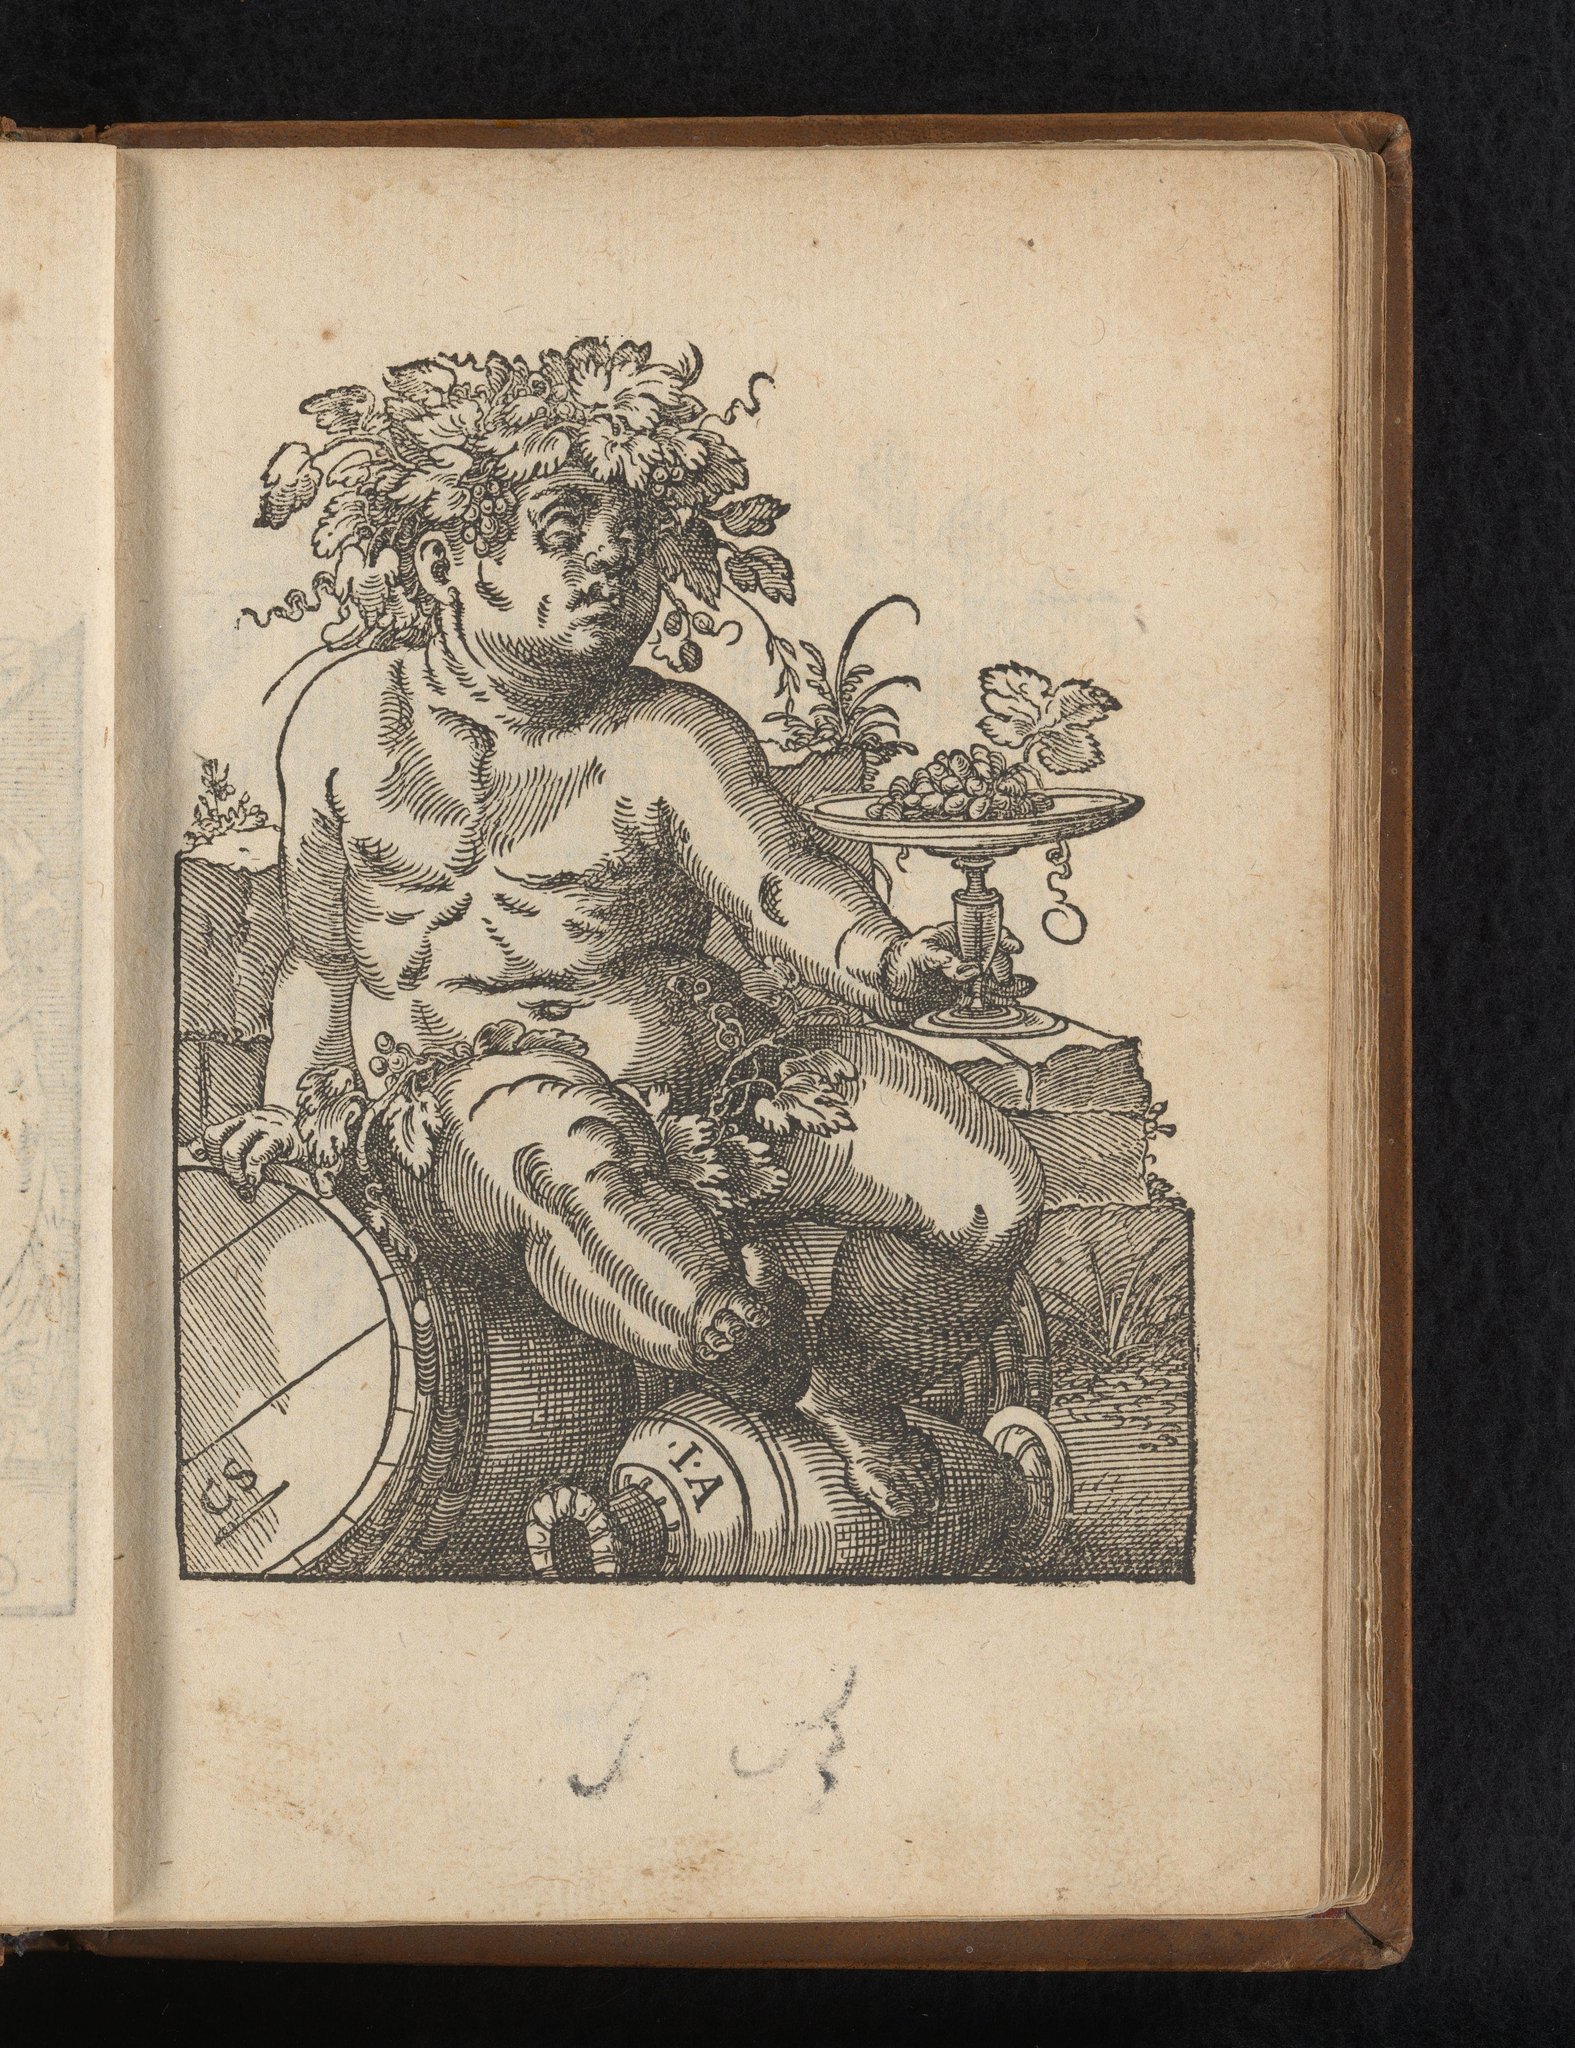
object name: print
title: Bacchus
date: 1578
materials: paper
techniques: woodcut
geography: nuremberg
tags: children's bacchanal, the drunken bacchus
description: Bacchus als een naakt jongetje met druivenranken en -trossen op het hoofd, in de hand een drinkschaal, zittend op een wijnvat met een voet rustend op een wijnkan. Onderdeel van het modelboek Enchiridion artis pingendi, fingendi & sculpendi met 108 figuren bedoeld voor beginnende schilders, beeldhouwers en prentmakers.